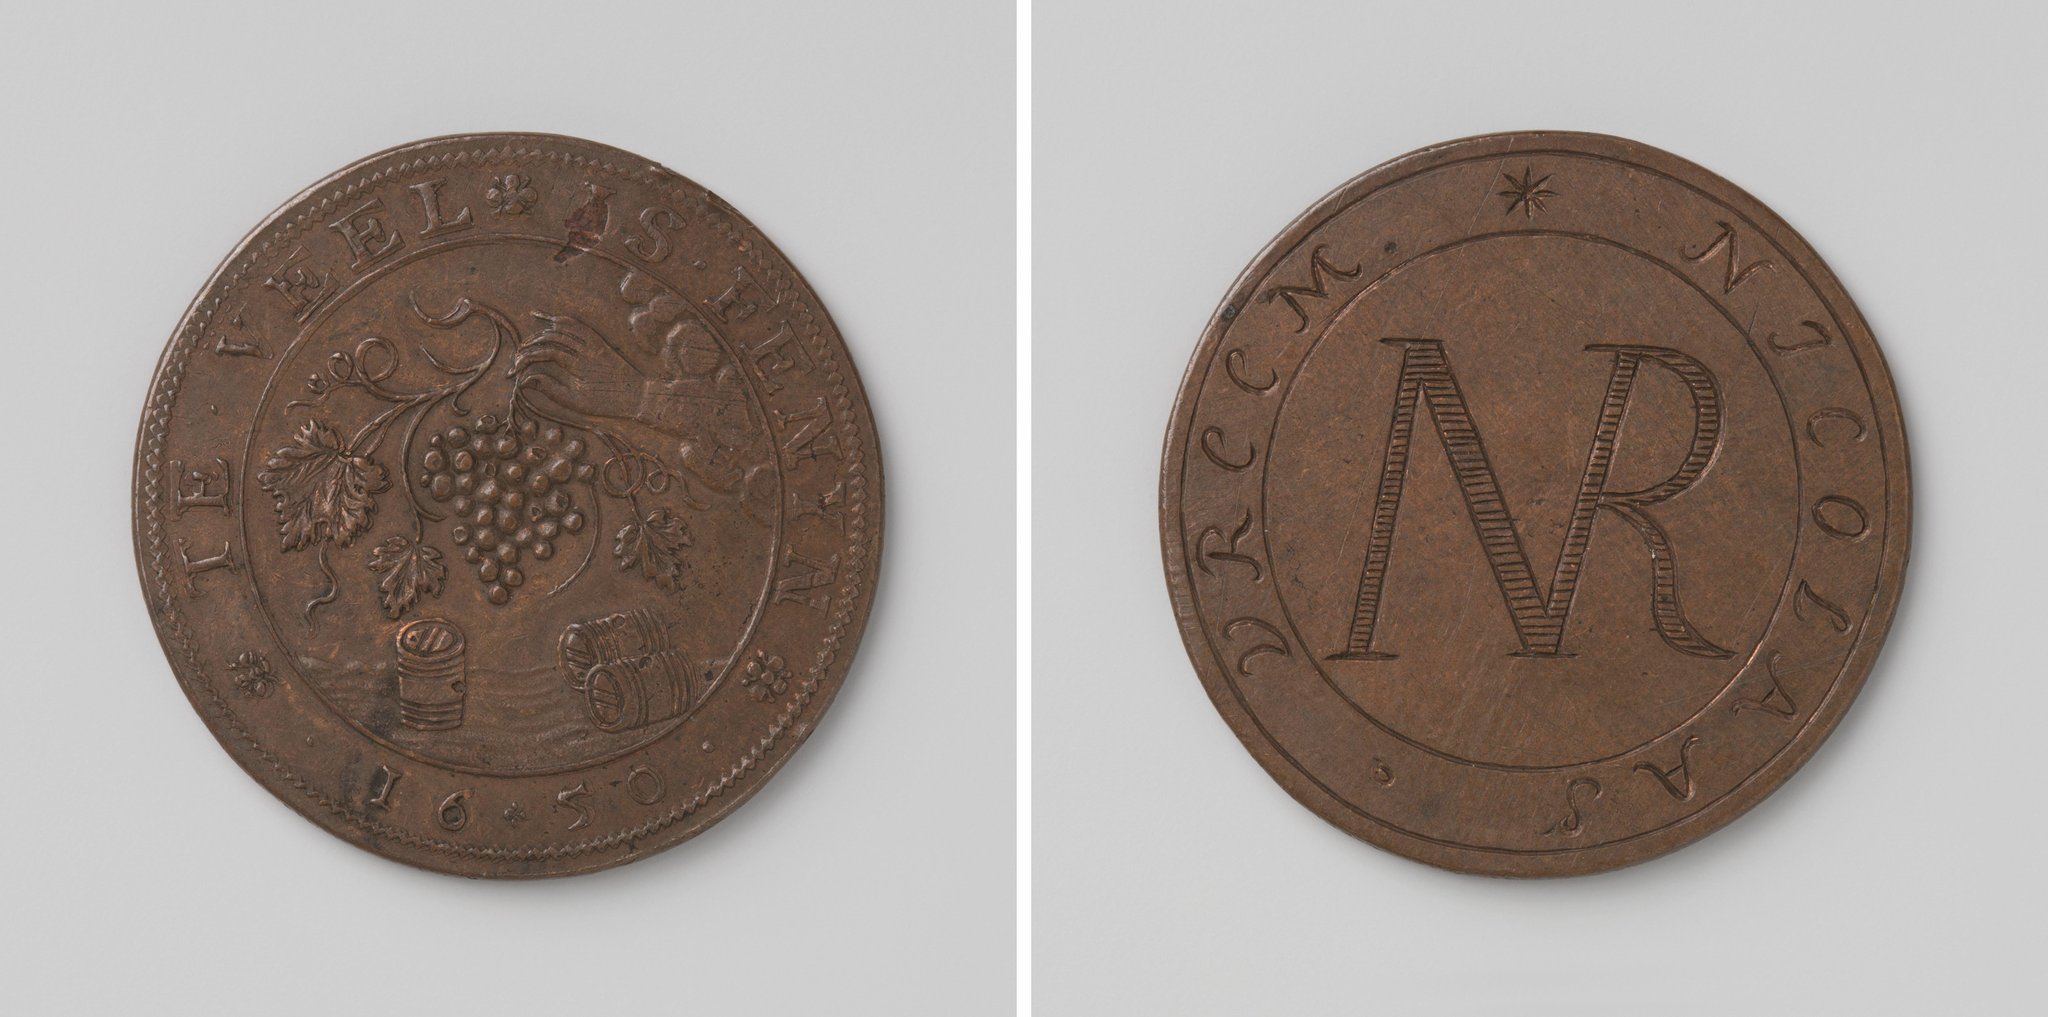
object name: medal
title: Wijnkopersgilde van Utrecht, gildepenning van Nicolaas Vreem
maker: Anonymous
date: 1650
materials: copper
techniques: engraving, striking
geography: utrecht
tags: utrecht